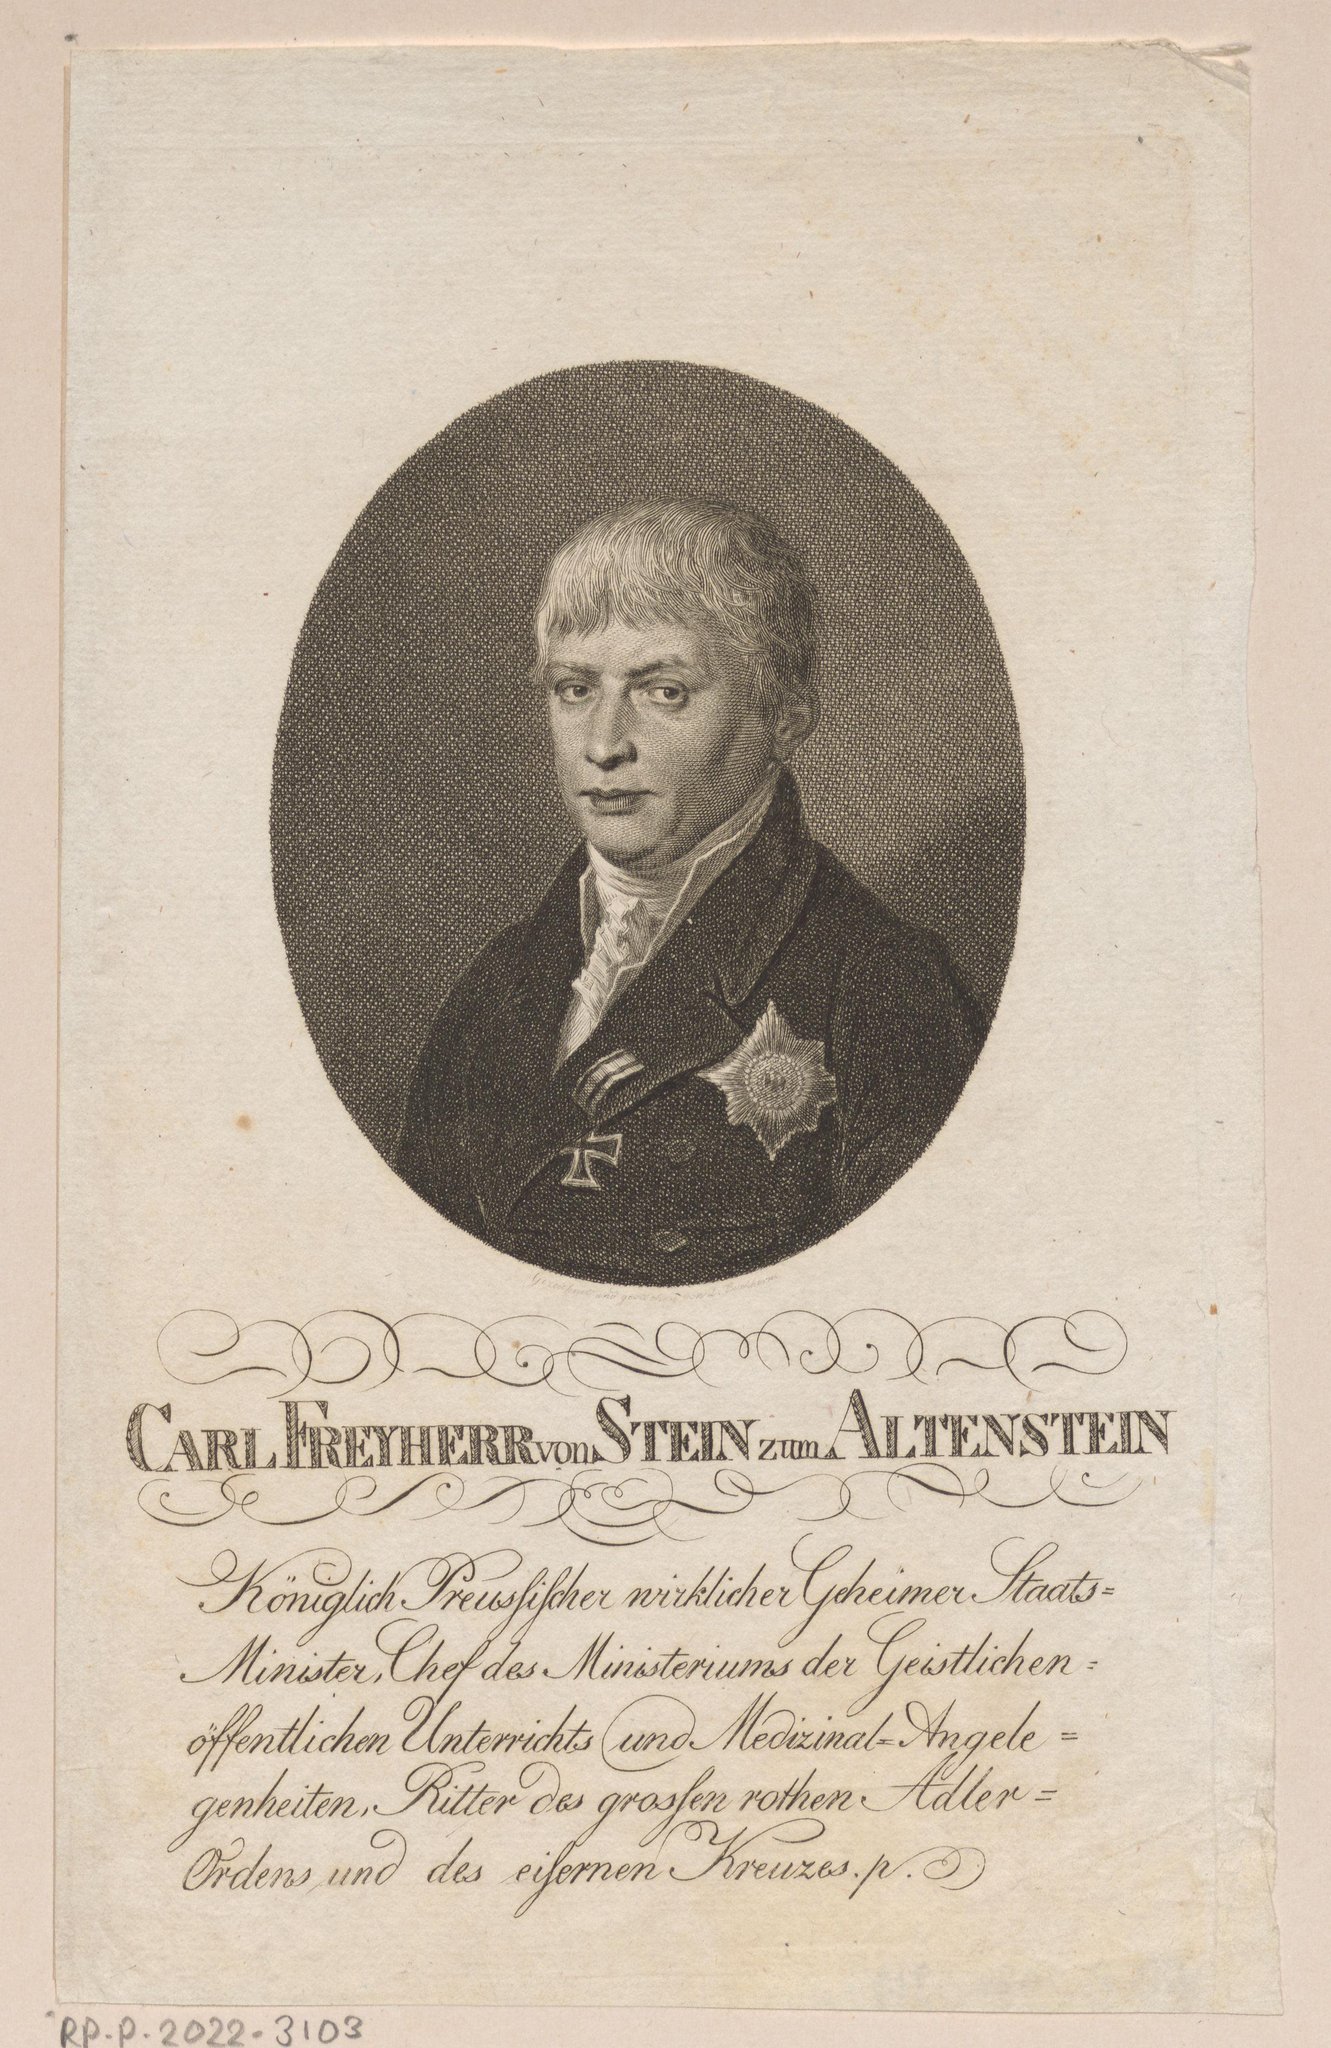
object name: print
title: Portret van Karl vom Stein zum Altenstein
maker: ludwig buchhorn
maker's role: painter, print maker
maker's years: 1770-1856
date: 1799-1856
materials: paper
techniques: engraving, etching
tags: berlin, politician, historical persons, politician, e.g. party leader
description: Met vijfregelig onderschrift in het Duits.